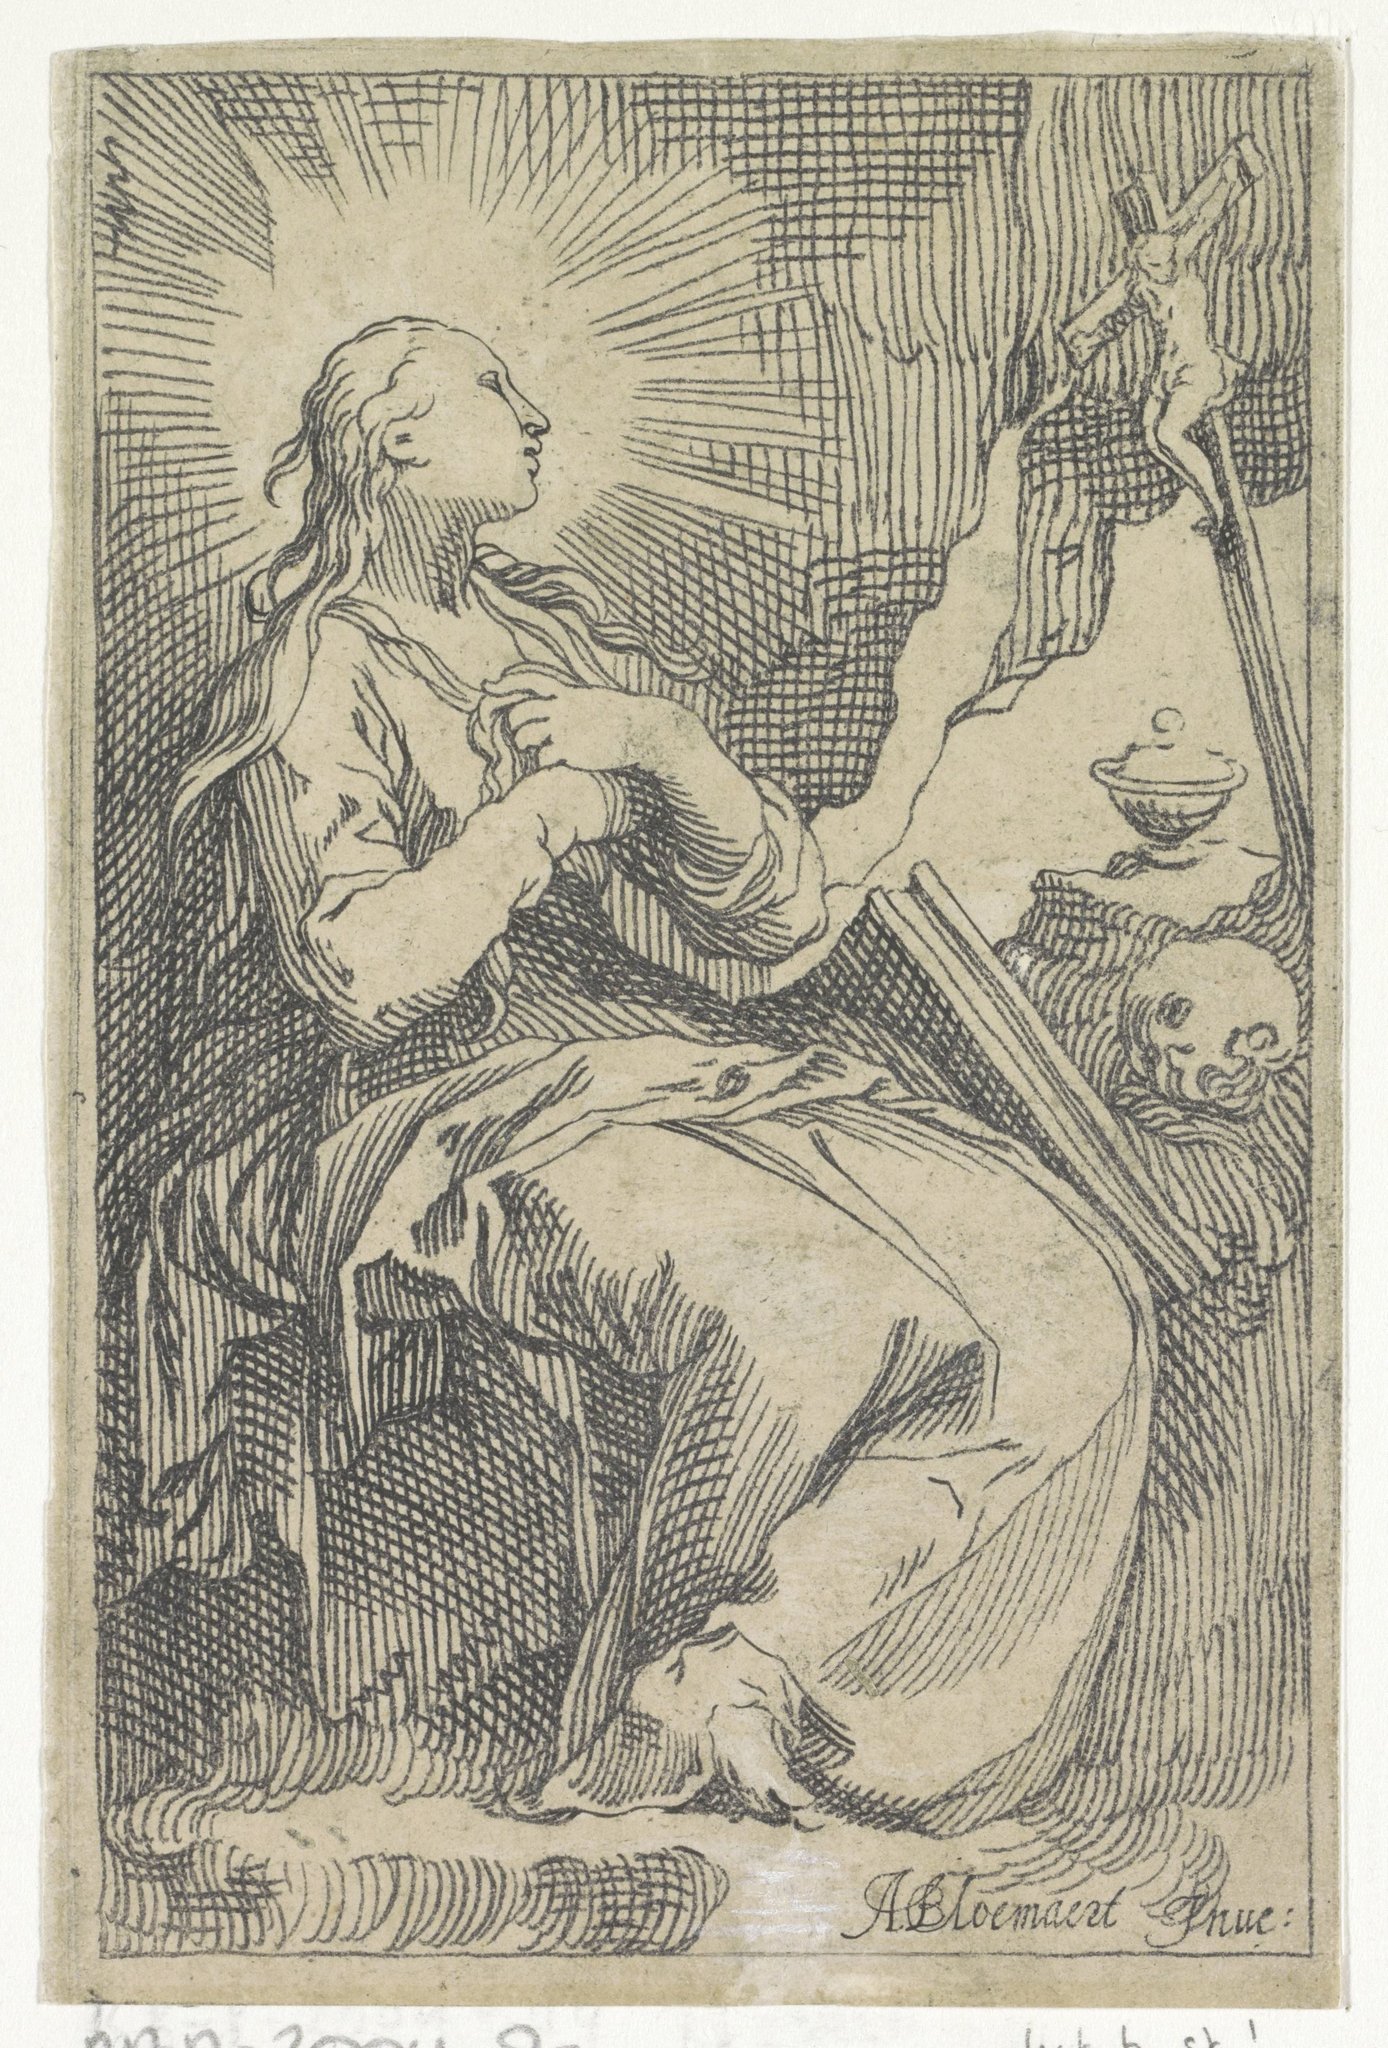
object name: print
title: Boetvaardige Maria Magdalena in de grot voor een crucifix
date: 1610-1615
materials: paint, paper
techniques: brush, woodcut, etching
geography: netherlands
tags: the penitent harlot mary magdalene; possible attributes: book (or scroll), crown, crown of thorns, crucifix, jar of ointment, mirror, musical instrument, palm-branch, rosary, scourge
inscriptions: collector's mark: Lugt 2228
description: Er zijn drie verschillende platen met dezelfde voostelling gemaakt. Dit is de eerste staat van plaat B.